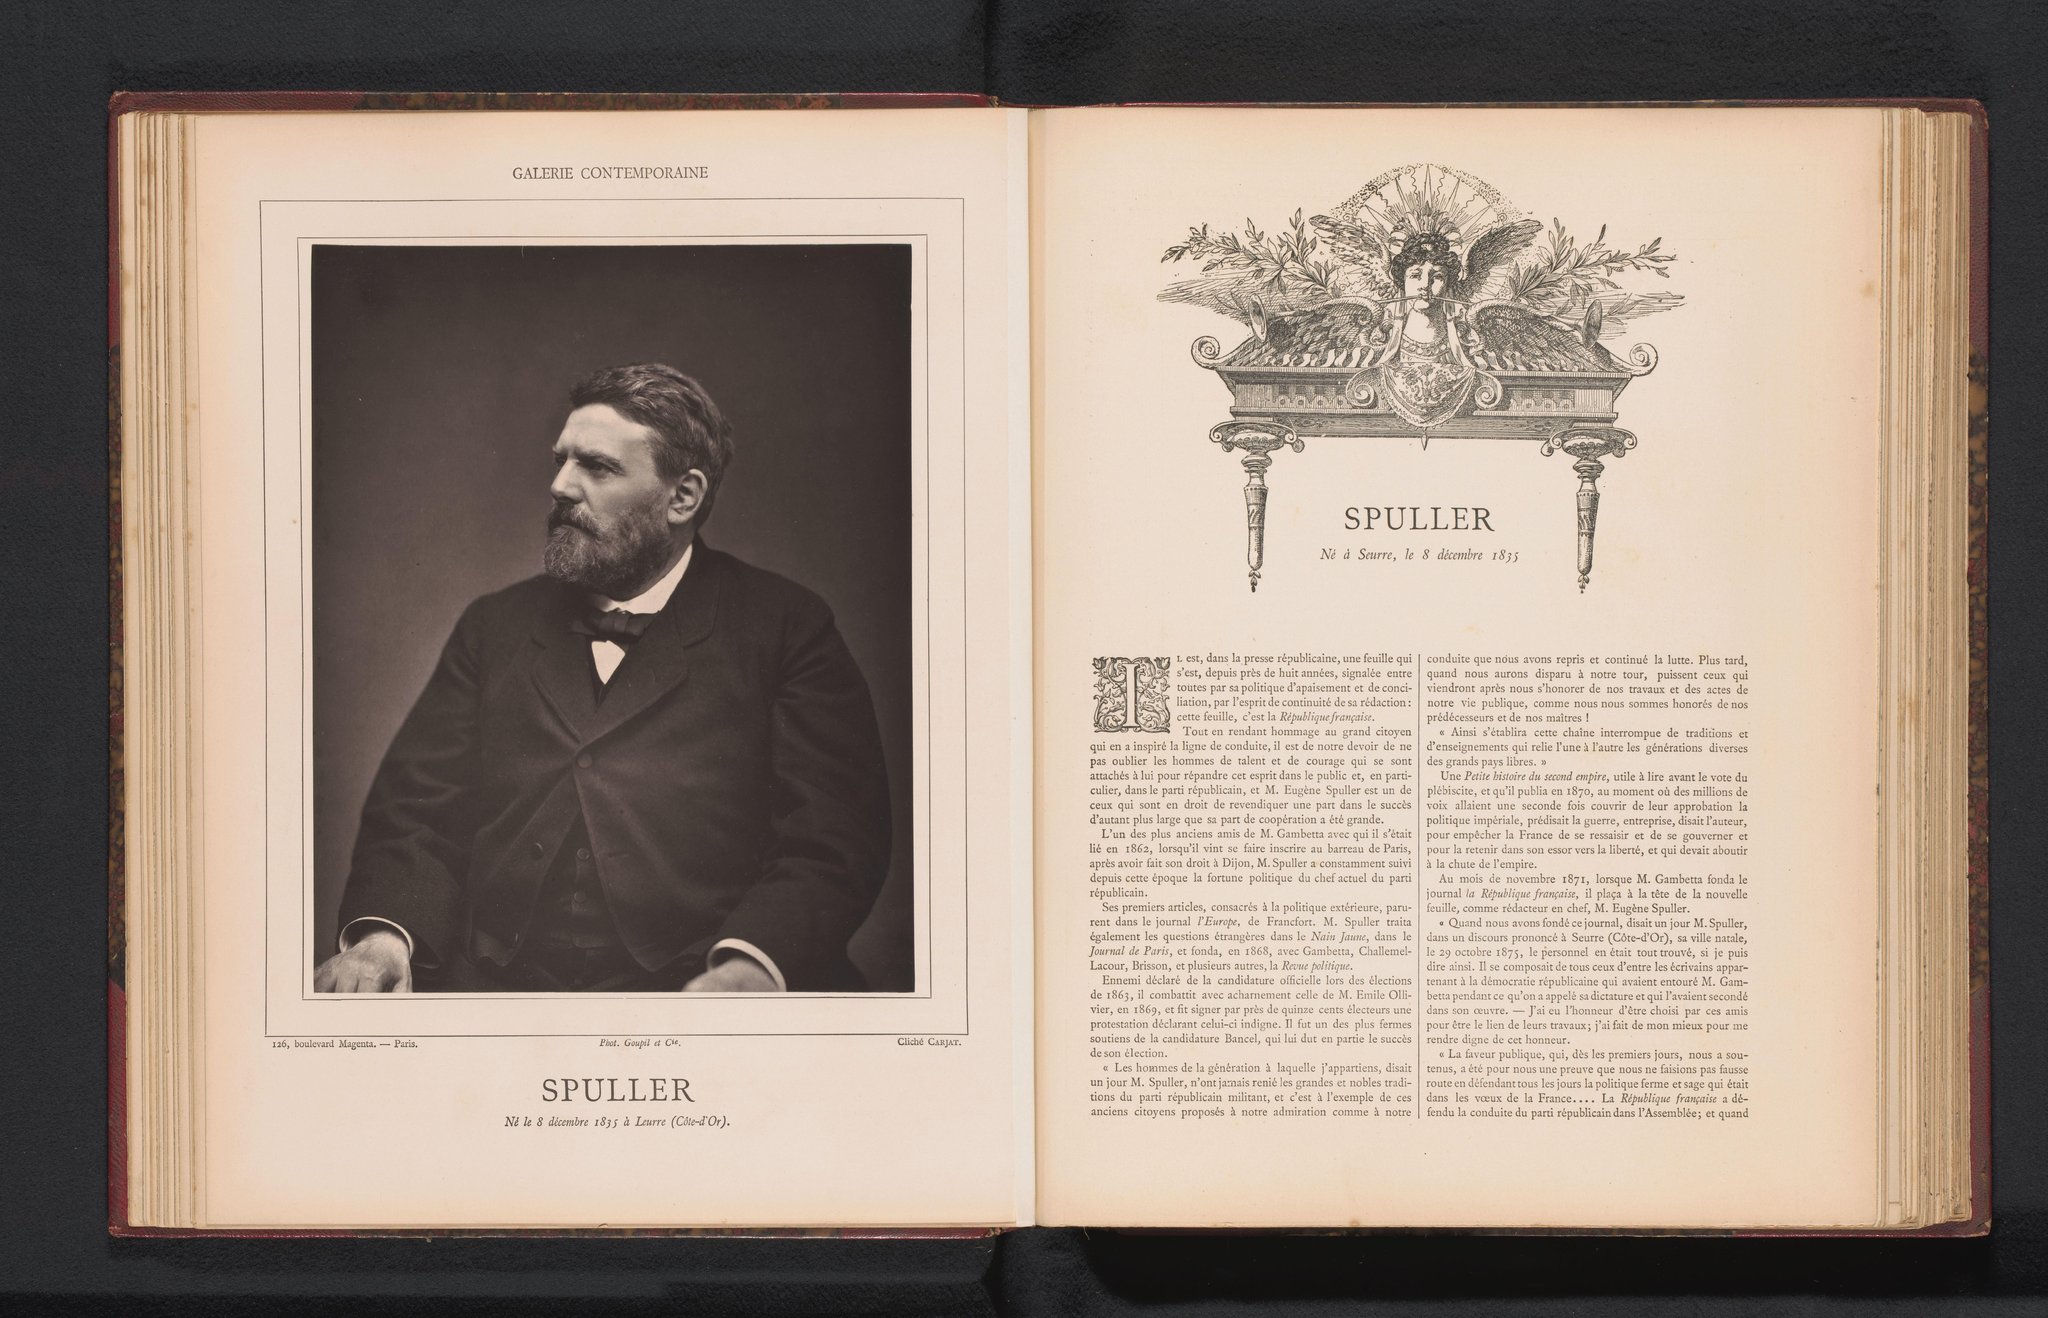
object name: photomechanical print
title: Spuller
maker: étienne carjat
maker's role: draughtsman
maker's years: 1828-1906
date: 1873-1878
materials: paper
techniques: woodburytype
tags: politician, adult man, historical persons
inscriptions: inscription: ‘Galerie Contemporaine, 126, boulevard Magenta. - Paris./ Né le 8 décembre 1835 à Leurre (Côte-d'Or).’